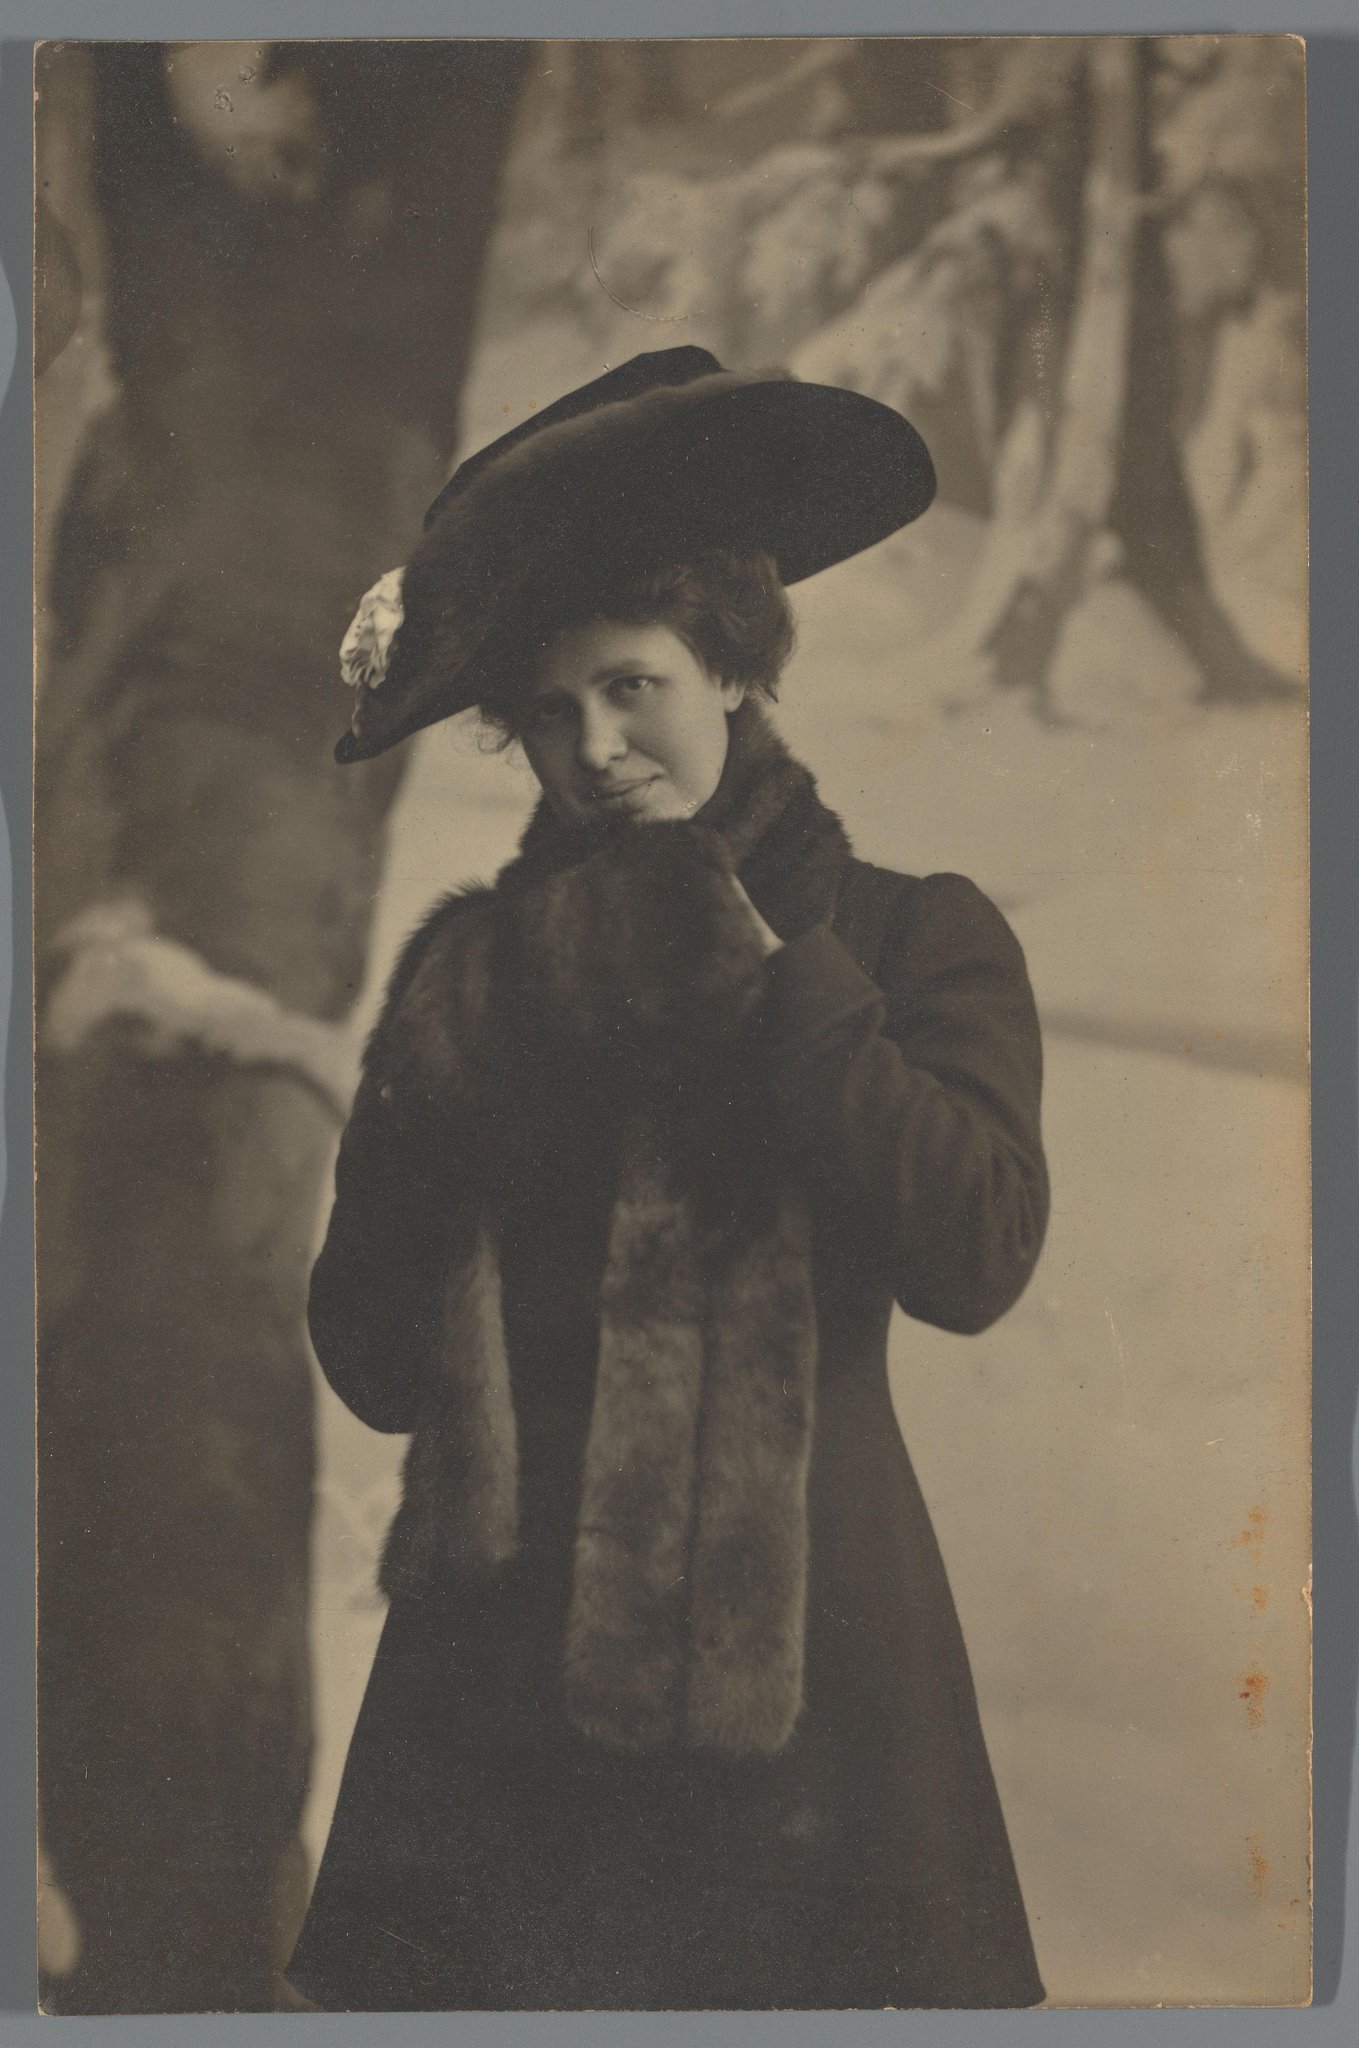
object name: photograph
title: Portret van tante Leo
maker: Anonymous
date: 1890-1920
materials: photographic support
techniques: photography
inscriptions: inscription: ‘tante Leo’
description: Vrouw met hoed in besneeuwd boslandschap.